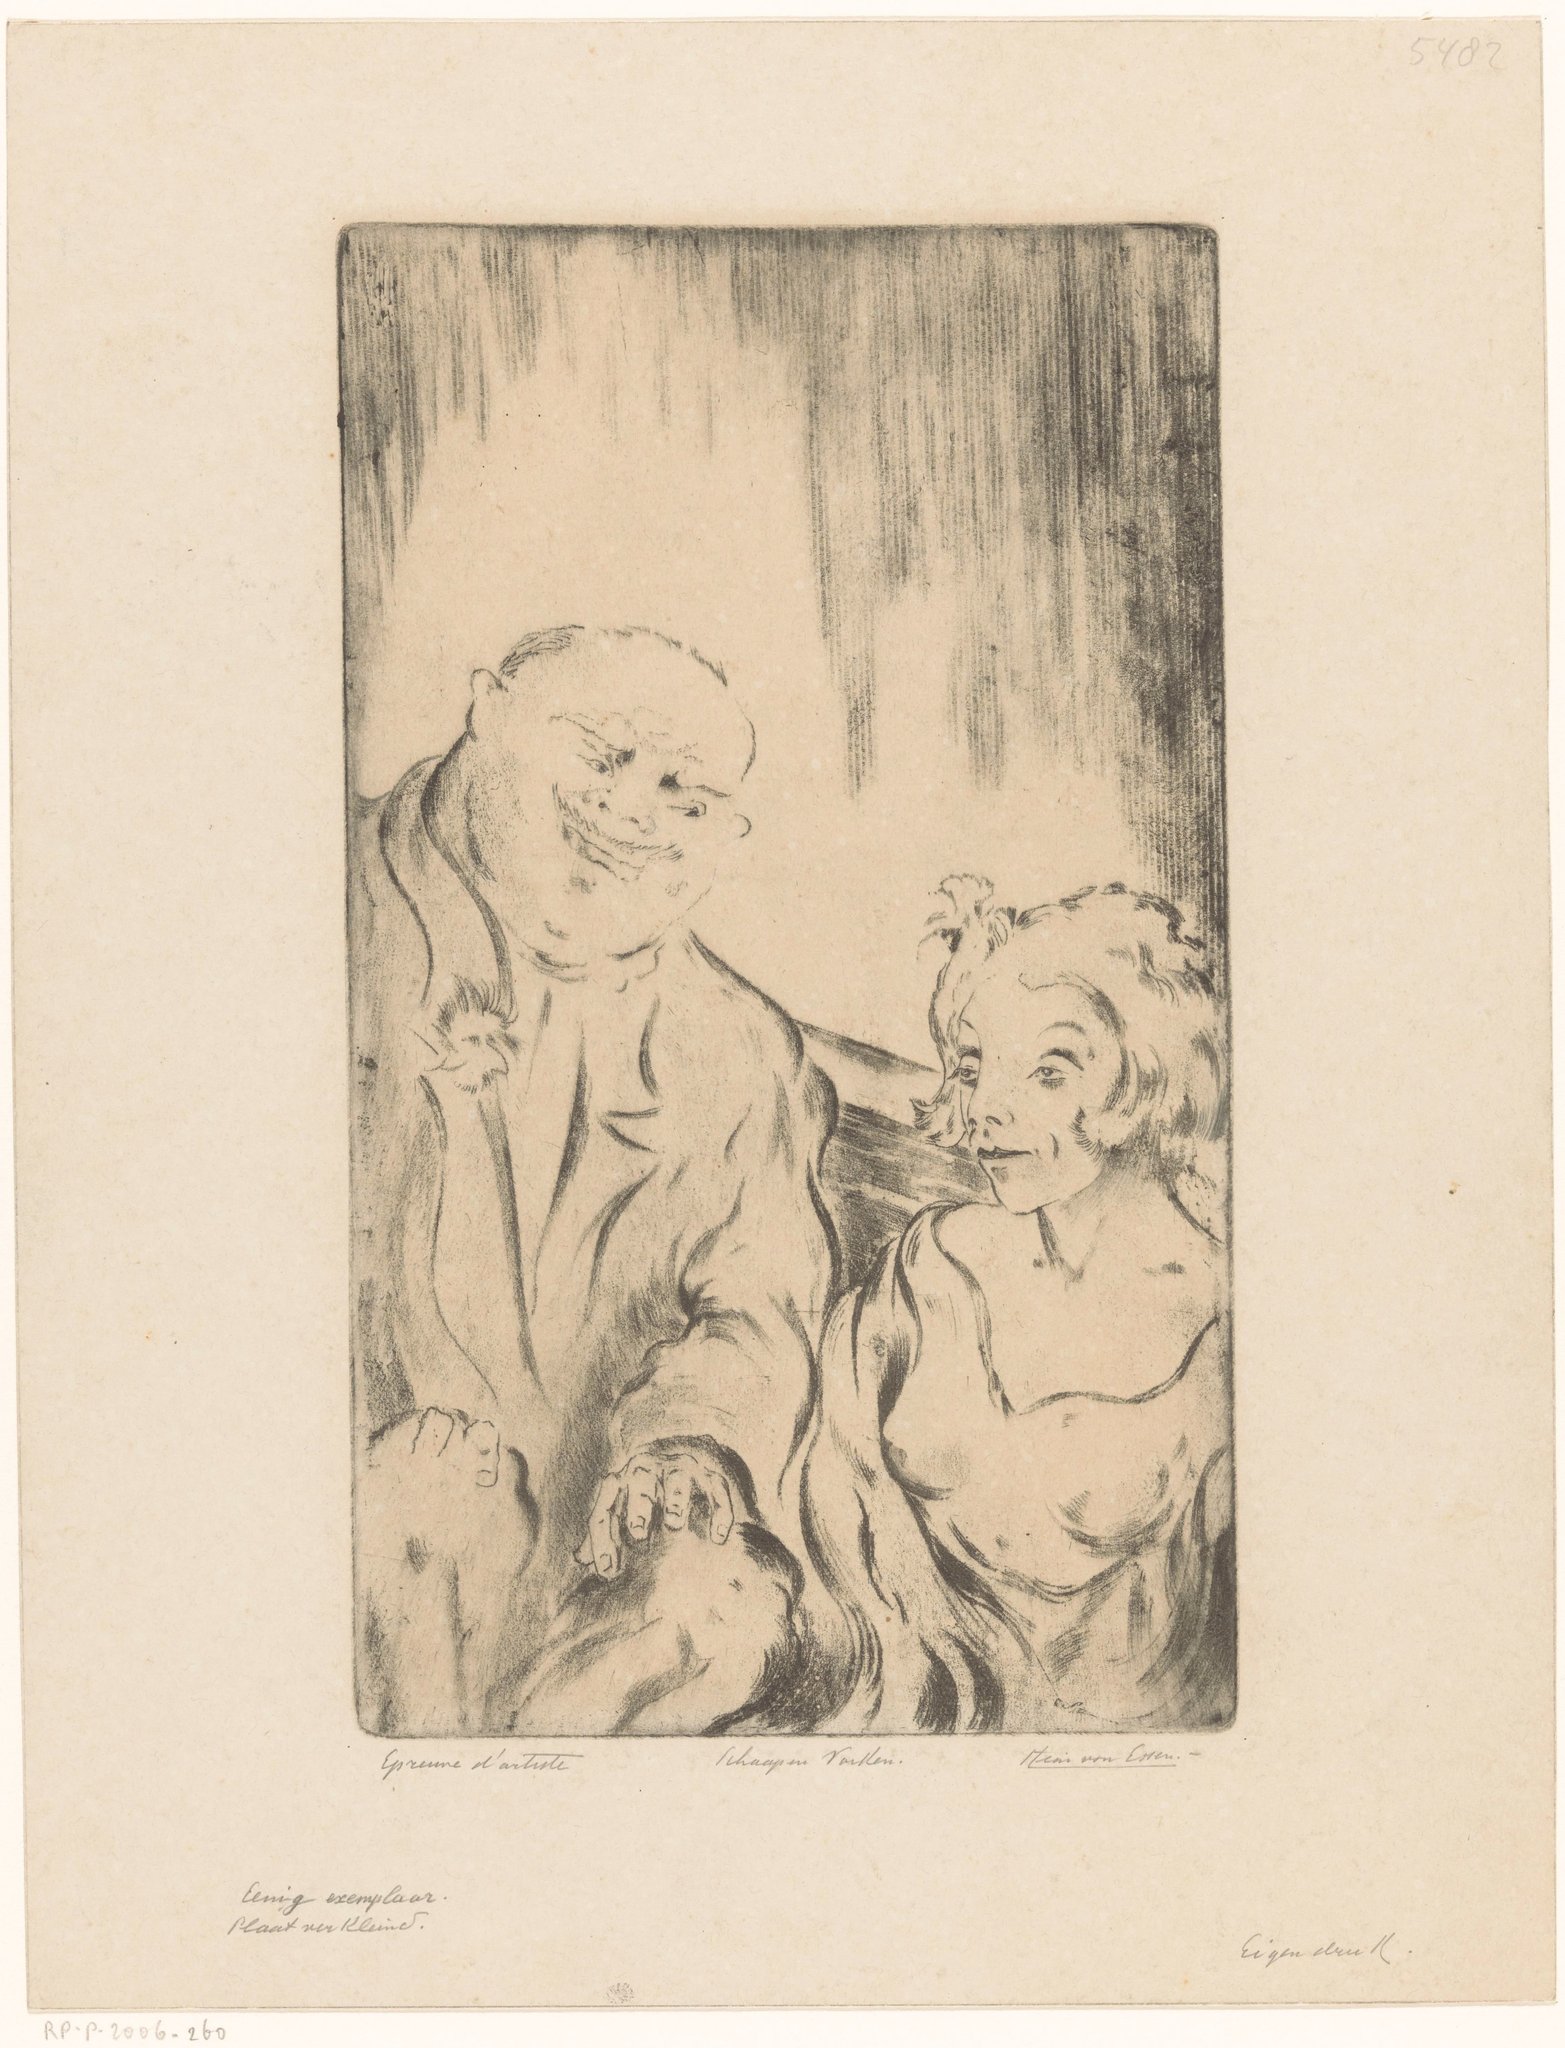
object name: print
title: Man en vrouw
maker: hein von essen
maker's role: print maker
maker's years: 1886-1947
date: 1928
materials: paper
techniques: etching, soft ground etching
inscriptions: inscription: ‘Epreuve d'artiste // Schaap en Varken // Hein von Essen. // Eenig exemplaar. // Plaat verkleind. // Eigen druk.’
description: Een grote, grove man grijnst naar een vrouw, die schaapachtig voor zich uit kijkt.